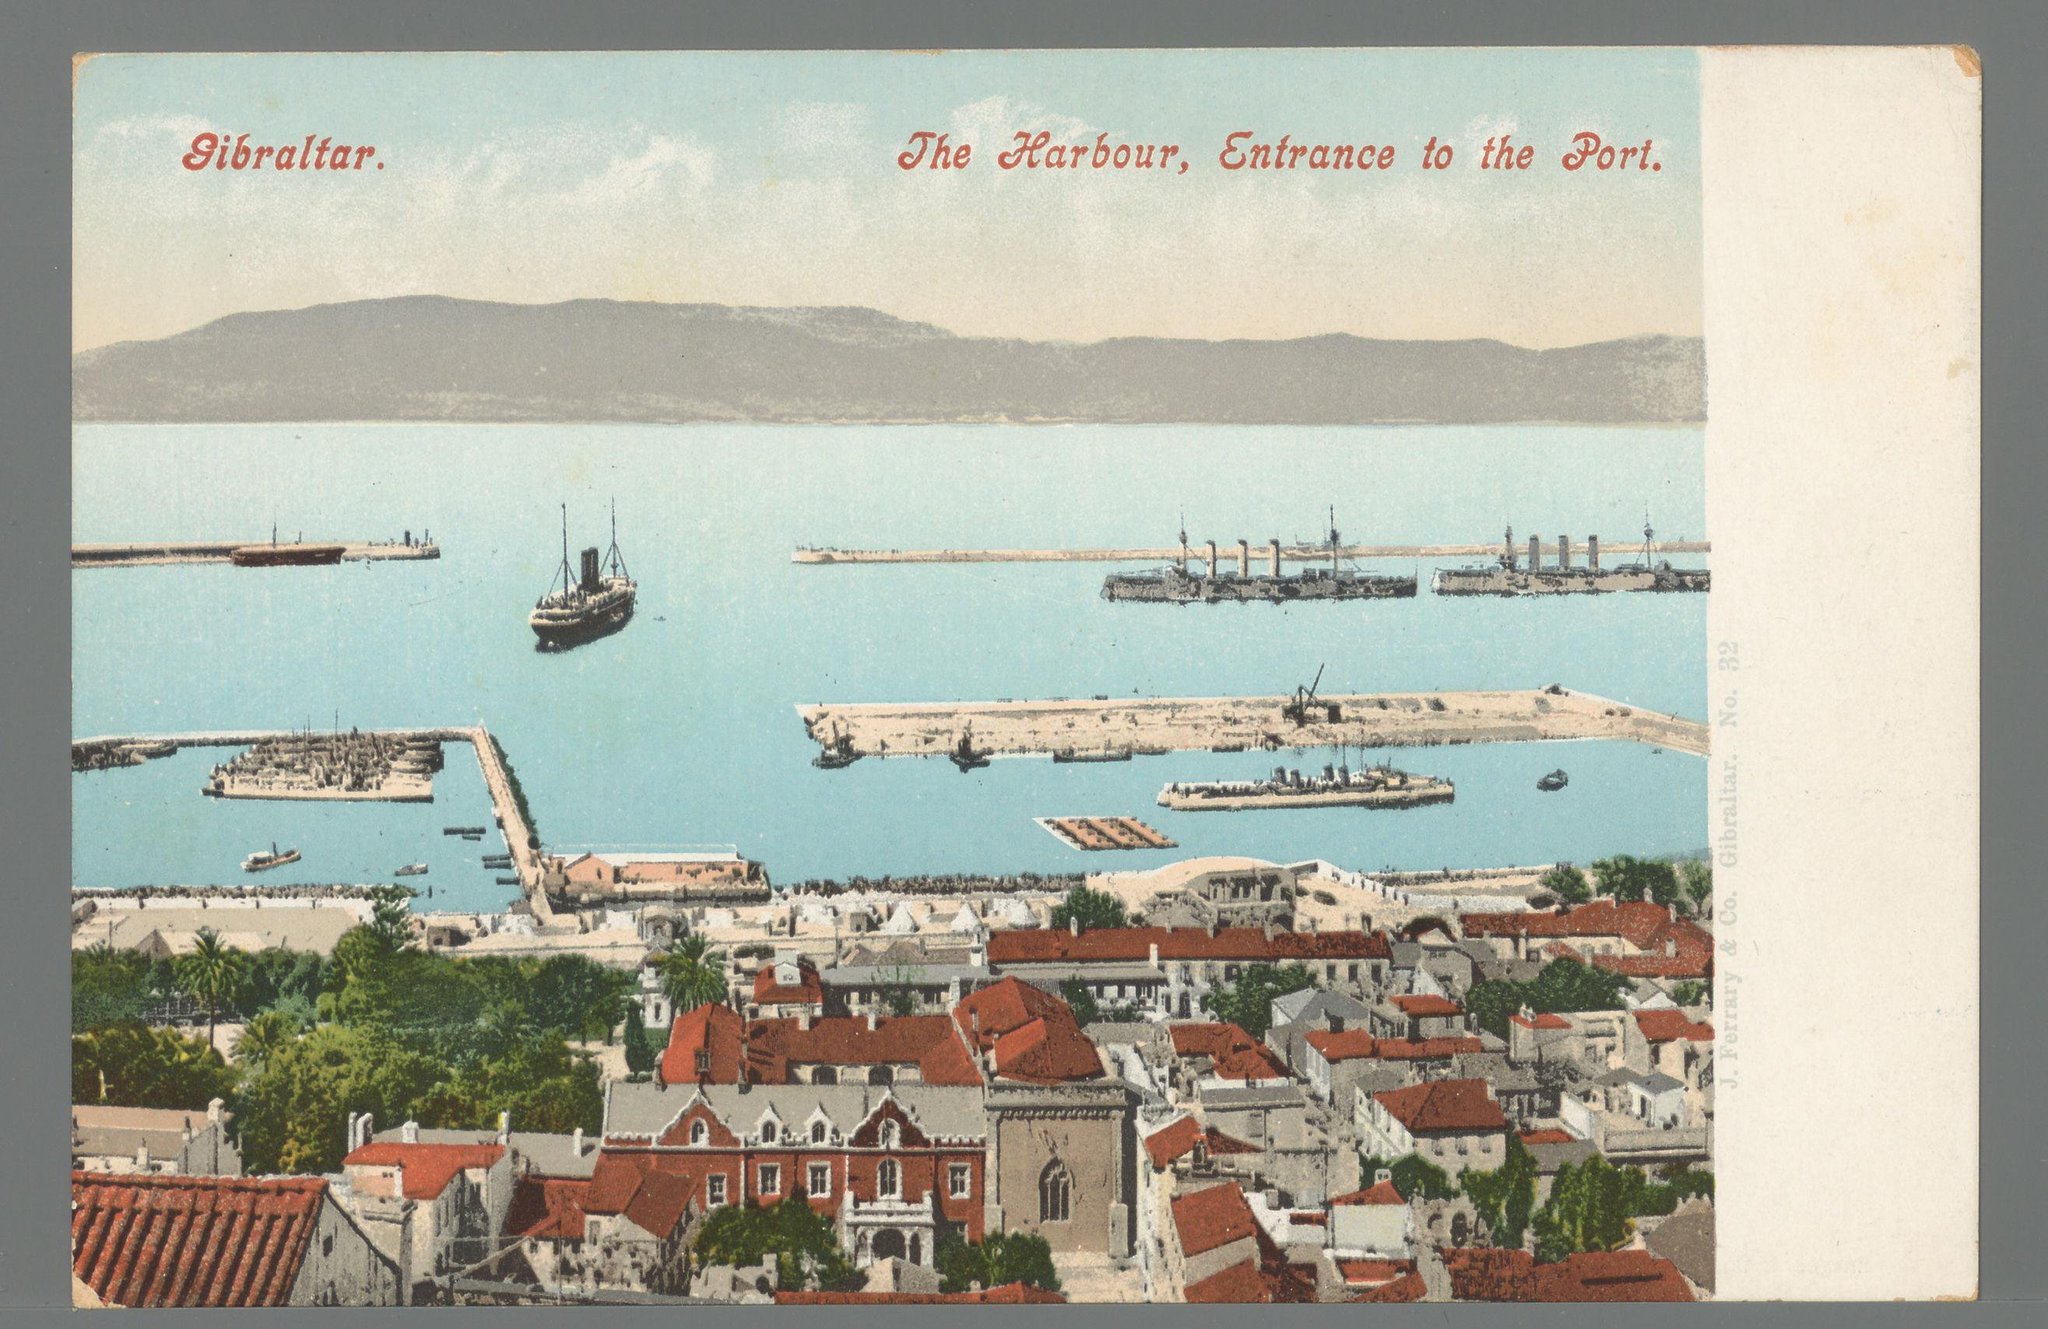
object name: photomechanical print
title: Gibraltar. The Harbour, entrance to the Port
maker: Anonymous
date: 1890-1906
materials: cardboard, photographic process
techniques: writing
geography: munich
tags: harbour, sea